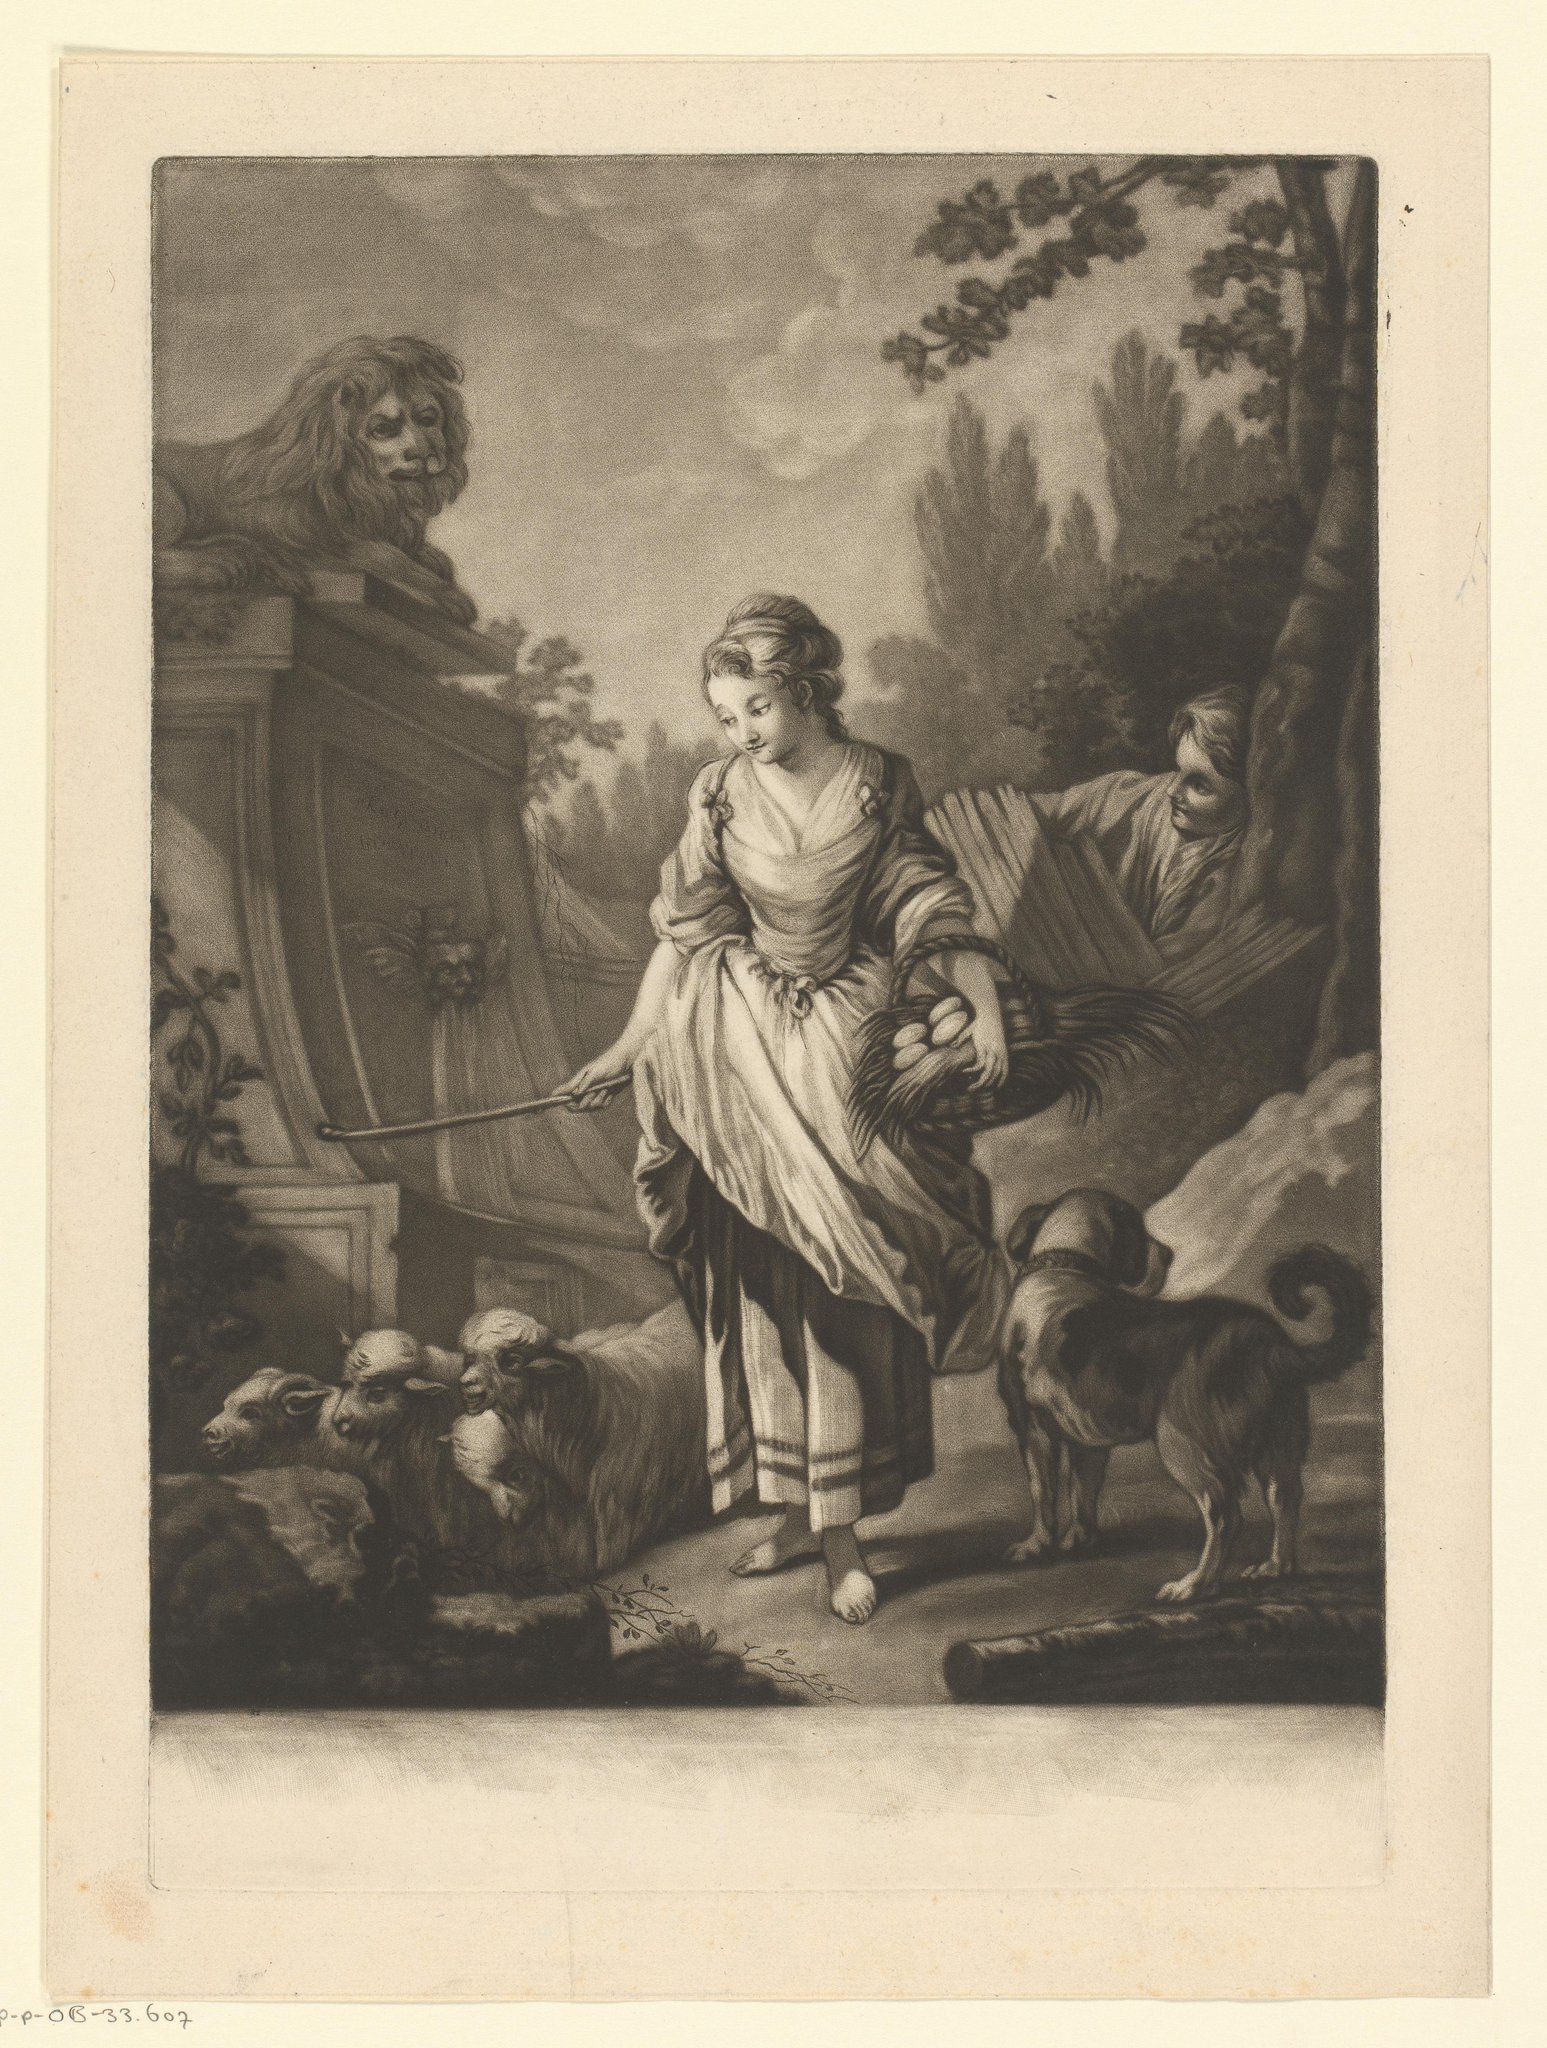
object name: print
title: Schaapsherderin met mand met eieren bij fontein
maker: Anonymous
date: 1765-1771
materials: paper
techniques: etching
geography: england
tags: herding, herdsman, herdswoman, shepherd, shepherdess, cowherd, etc., carrying something in basket, bag, rucksack, etc., sheep, ornamental fountain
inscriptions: collector's mark: Lugt 240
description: De prent is tussen 1765 en 1771 gepubliceerd door Ryland & Bryer. Zie hiervan een exemplaar in het British Museum (2010,7081.1162). De prent zelf werd mogelijk al eerder gemaakt.